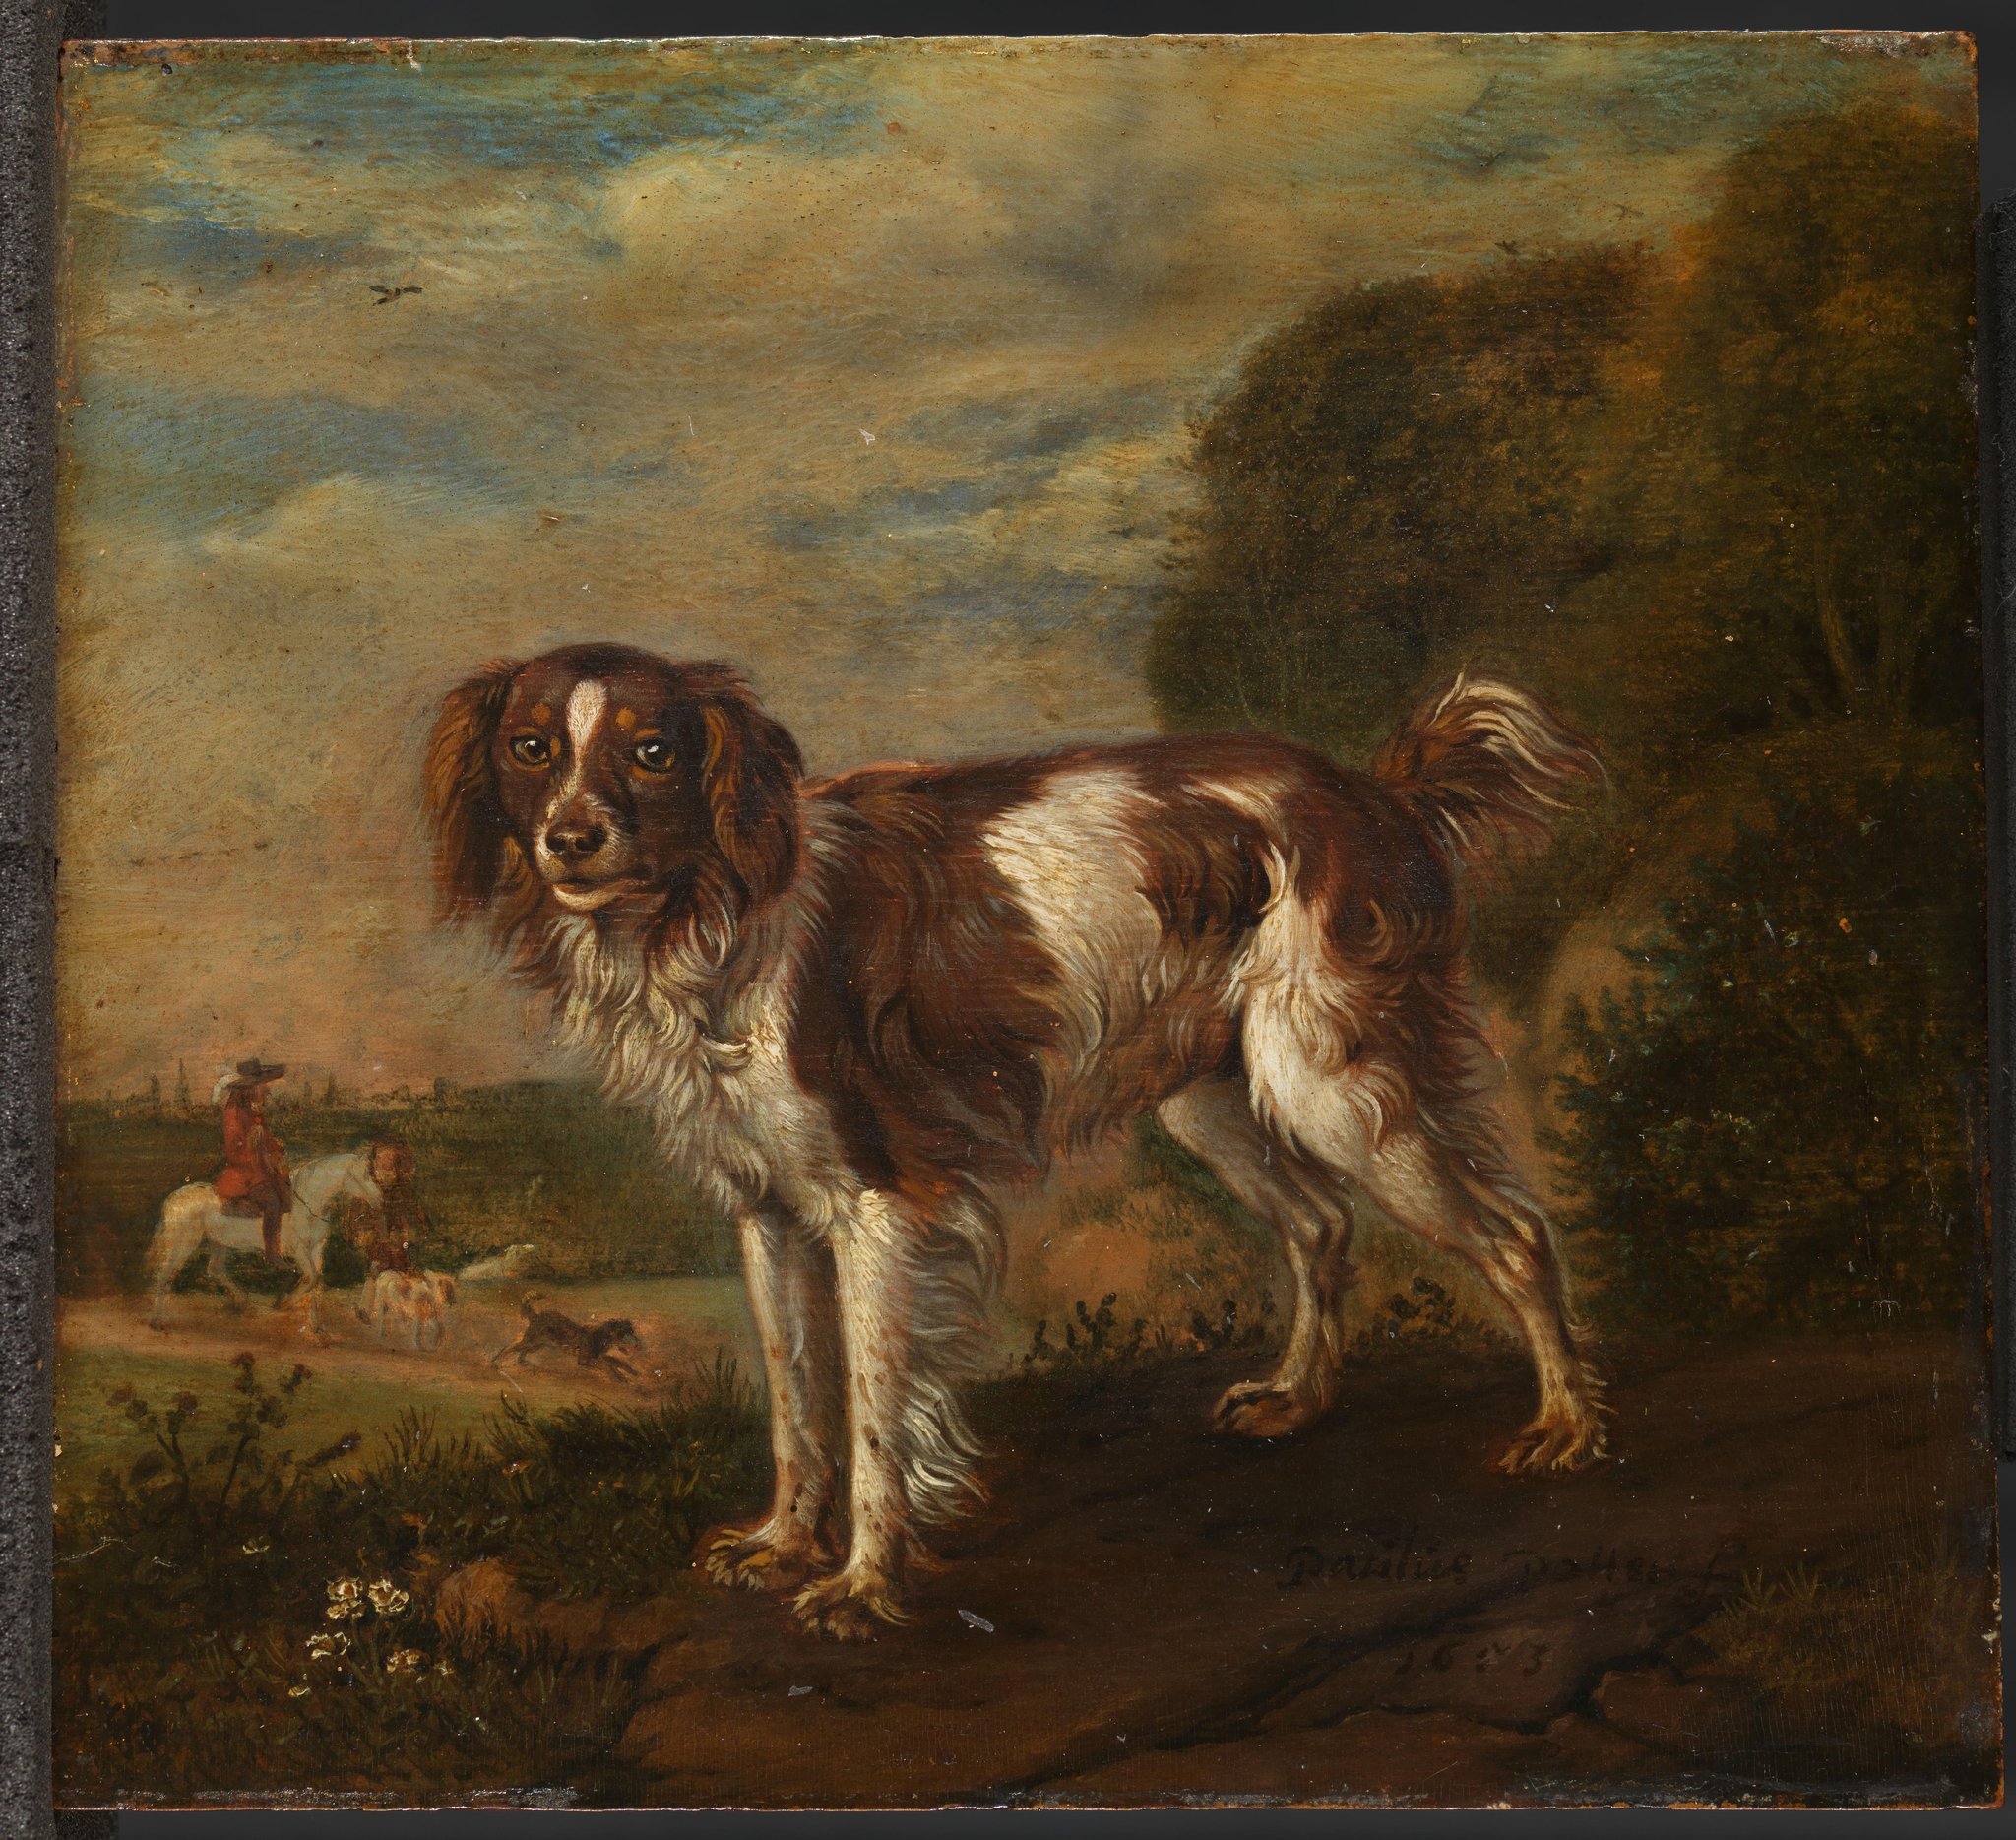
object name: painting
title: A spaniel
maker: paulus potter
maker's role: draughtsman, painter, print maker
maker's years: 1625-1654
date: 1653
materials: oil, panel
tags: dog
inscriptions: signature and date: ‘Paulus Potter f 1653’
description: Een patrijshond, op de achtergrond een landschap met een jager te paard met honden.